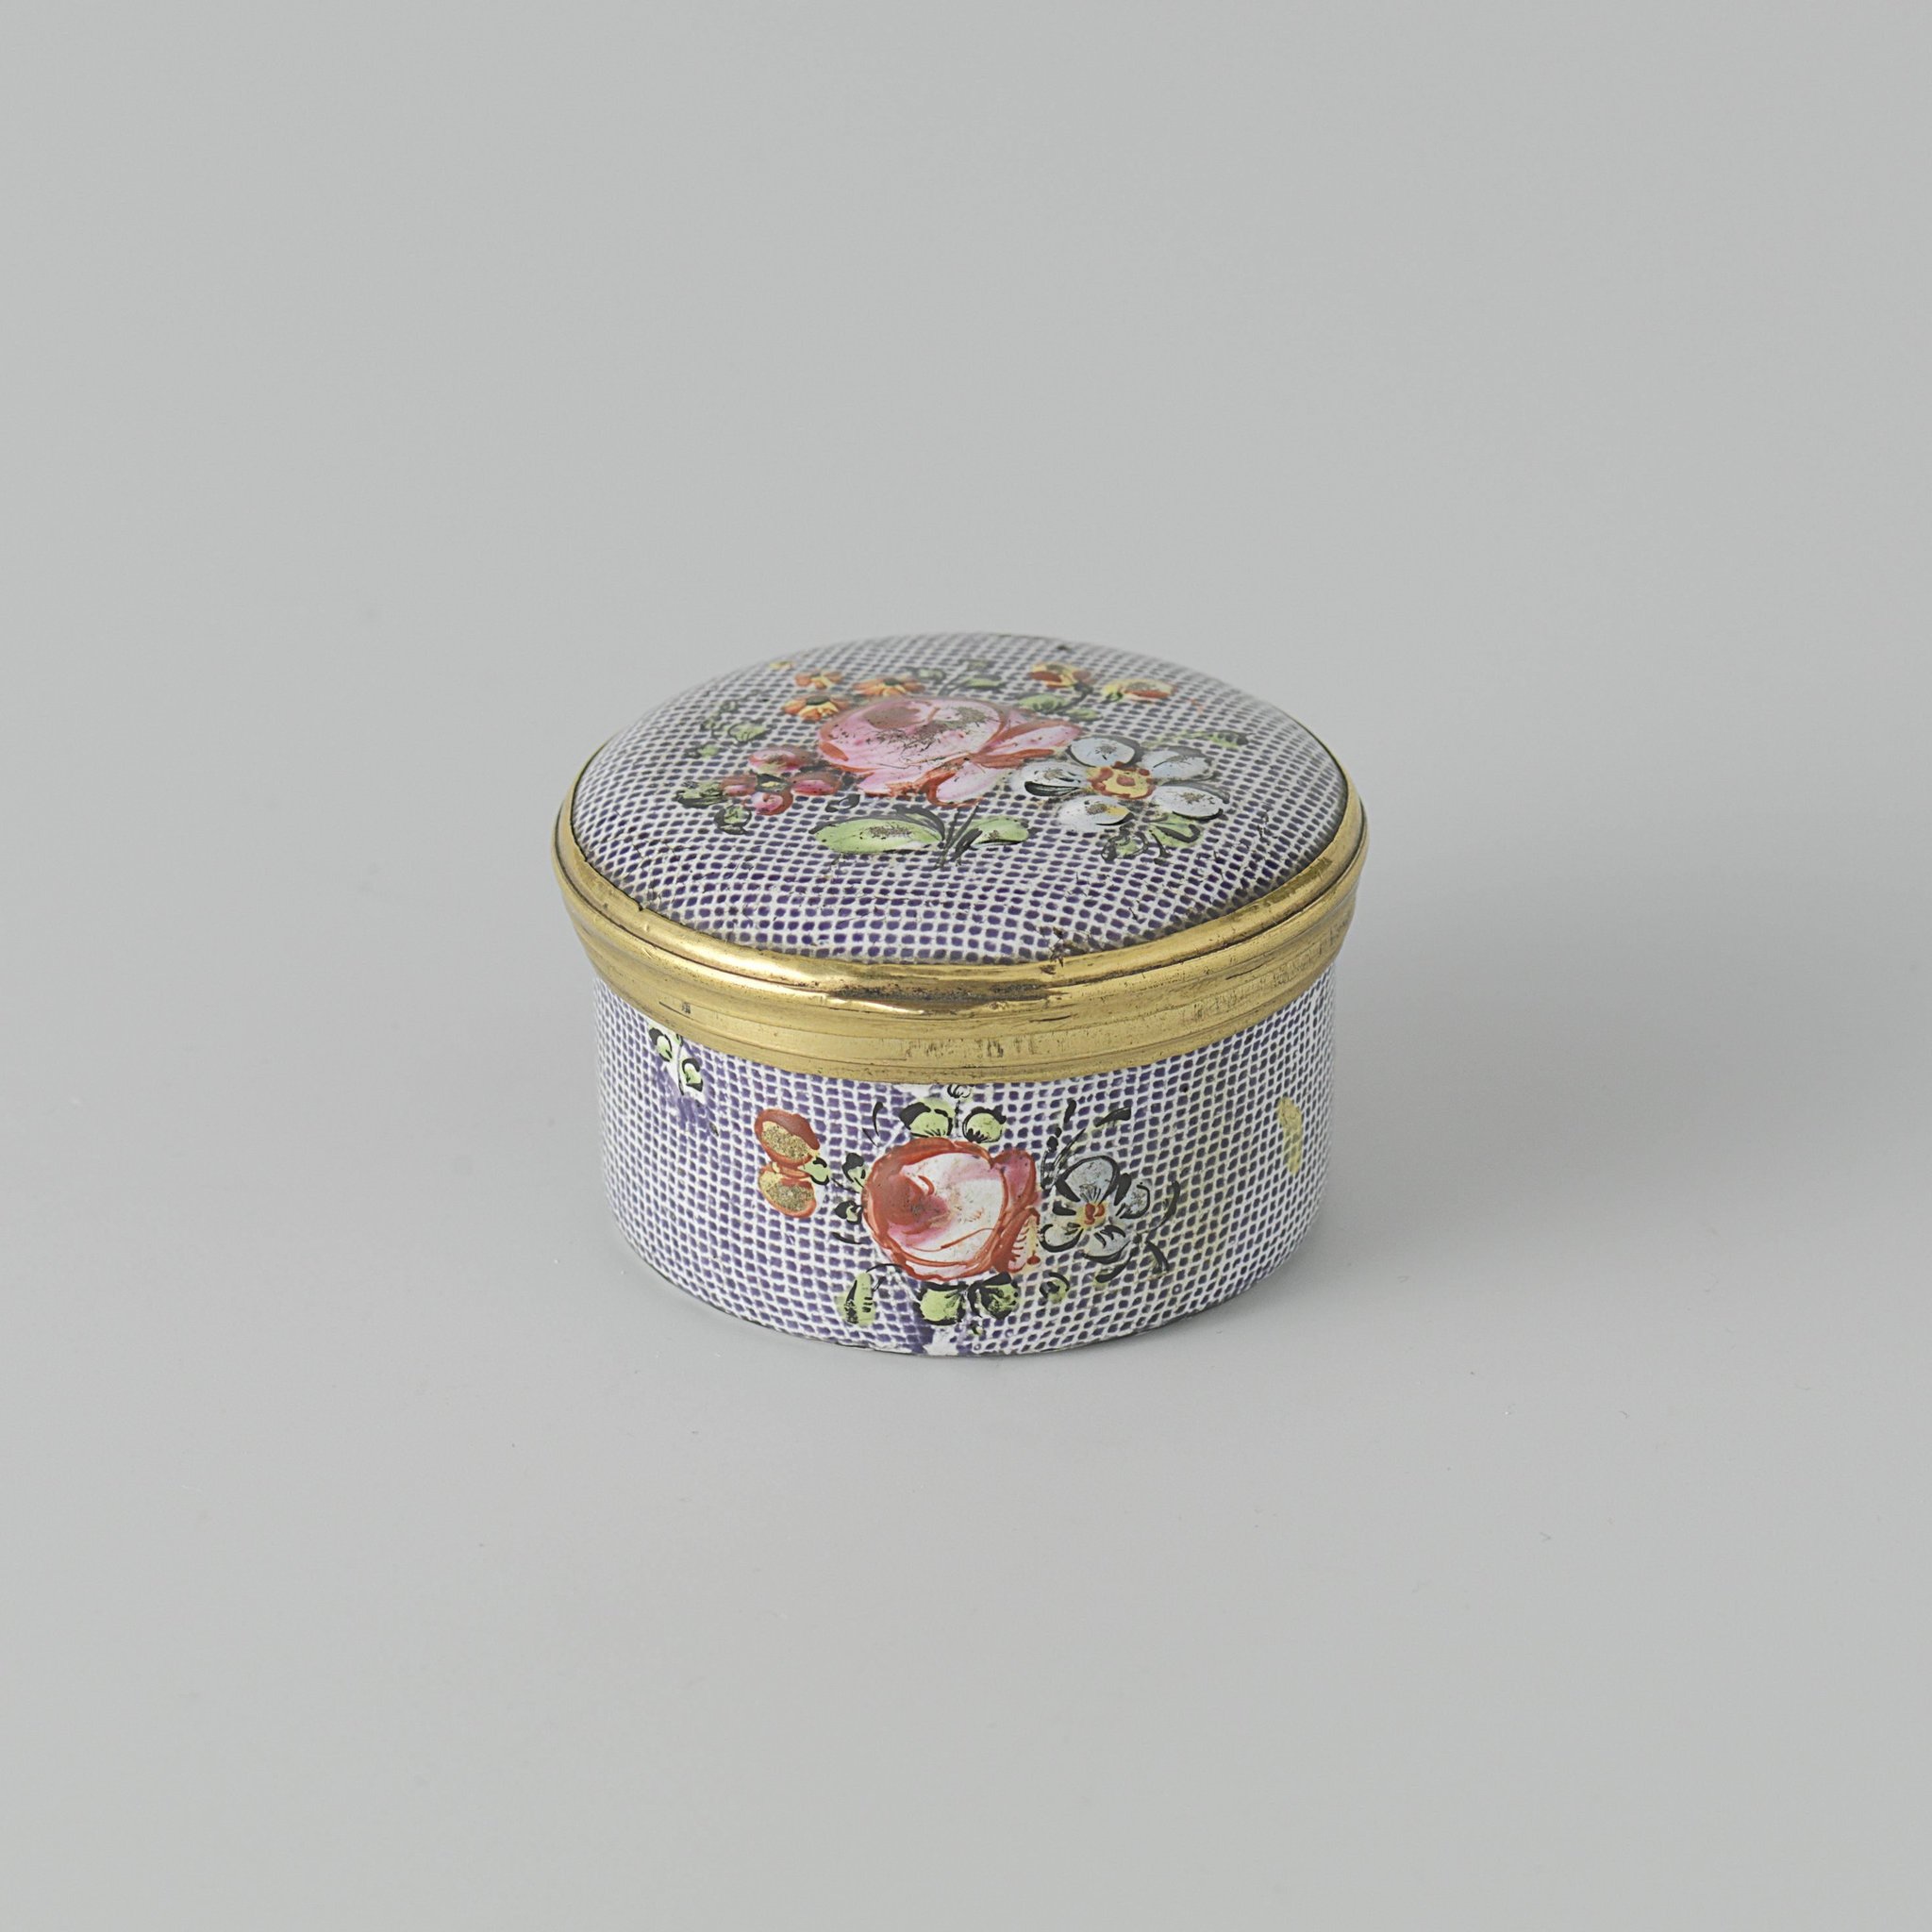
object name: snuffbox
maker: Anonymous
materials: enamel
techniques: enamel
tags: flowers ~ ornament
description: Snuifdoos, rond, van Battersea émail, met op de gewelfde deksel een bloemversiering in reliëf op een paarse weefselachtige fond.